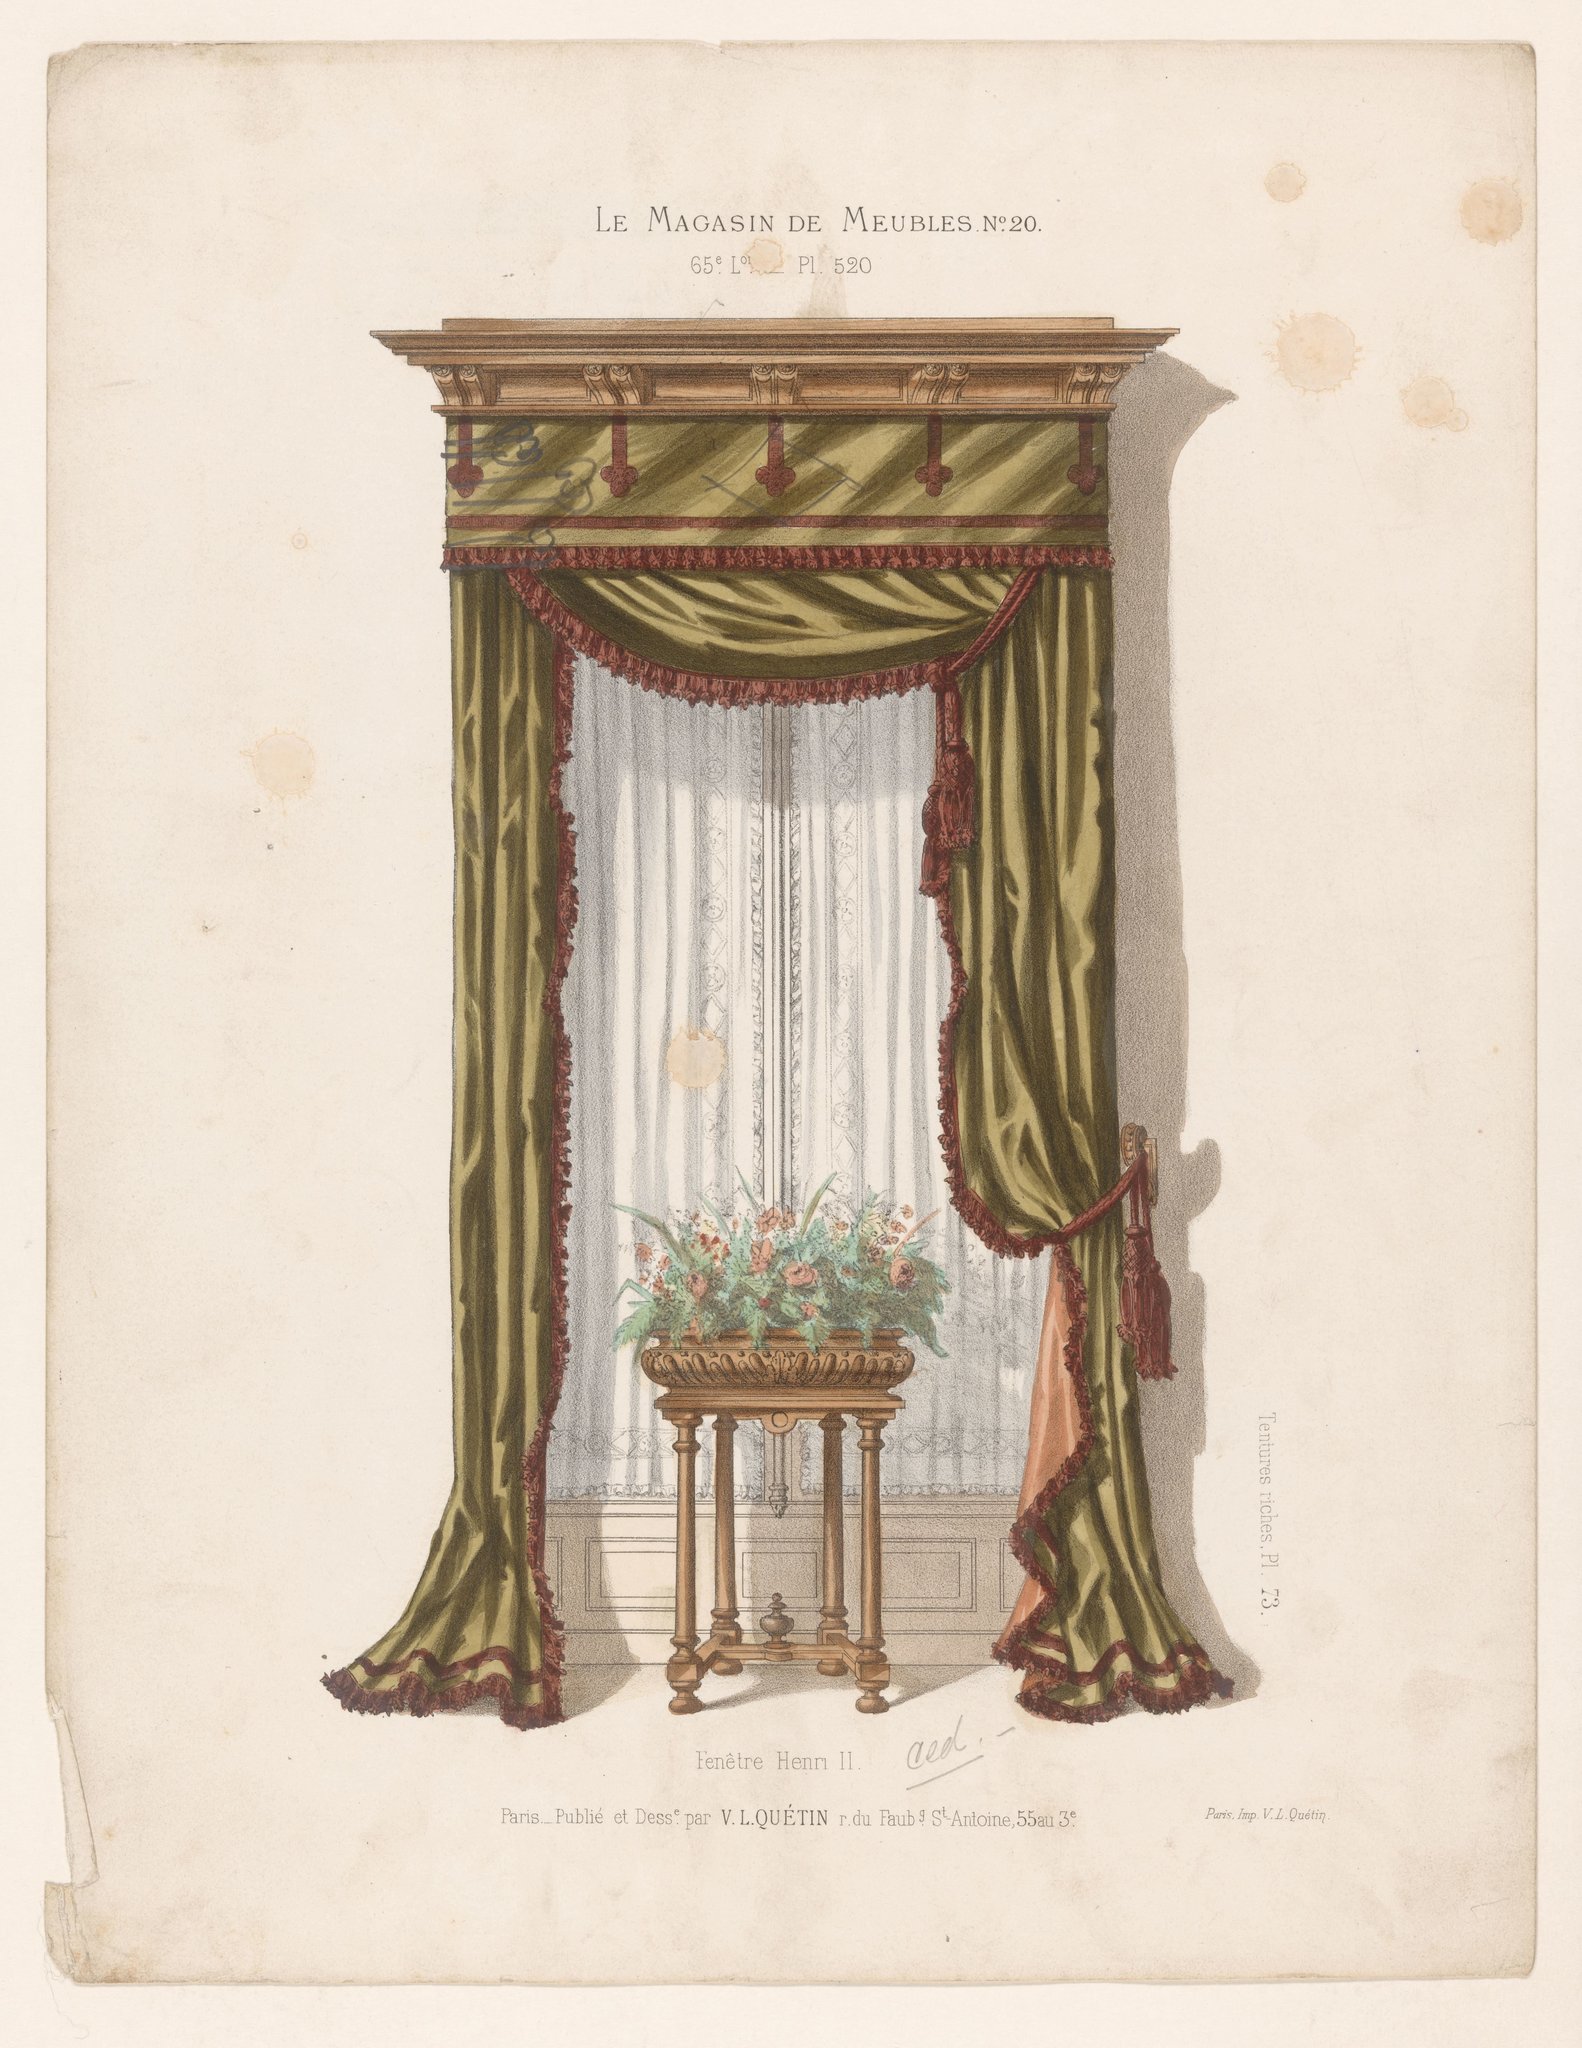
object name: print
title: Fenêtre Henri II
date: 1878-1904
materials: paper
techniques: hand coloring, lithograph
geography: paris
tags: window, table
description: Een vaas met bloemen op voetstuk voor een raam met gedrapeerde gordijnen, in Hendrik II-stijl. Prent uit 65e Livraison. Rechts onder de vermelding Tentures riches, Pl. 73.